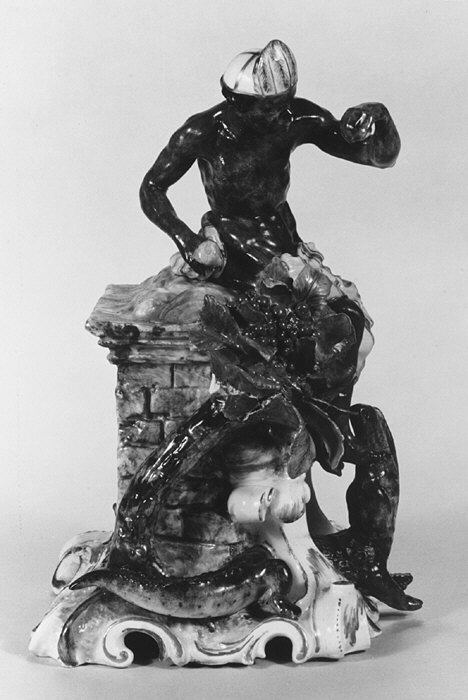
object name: figure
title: America (part of a set)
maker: nymphenburg porcelain manufactory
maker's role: manufactory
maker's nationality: german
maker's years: 1747-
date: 1763-1767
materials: hard paste porcelain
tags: men